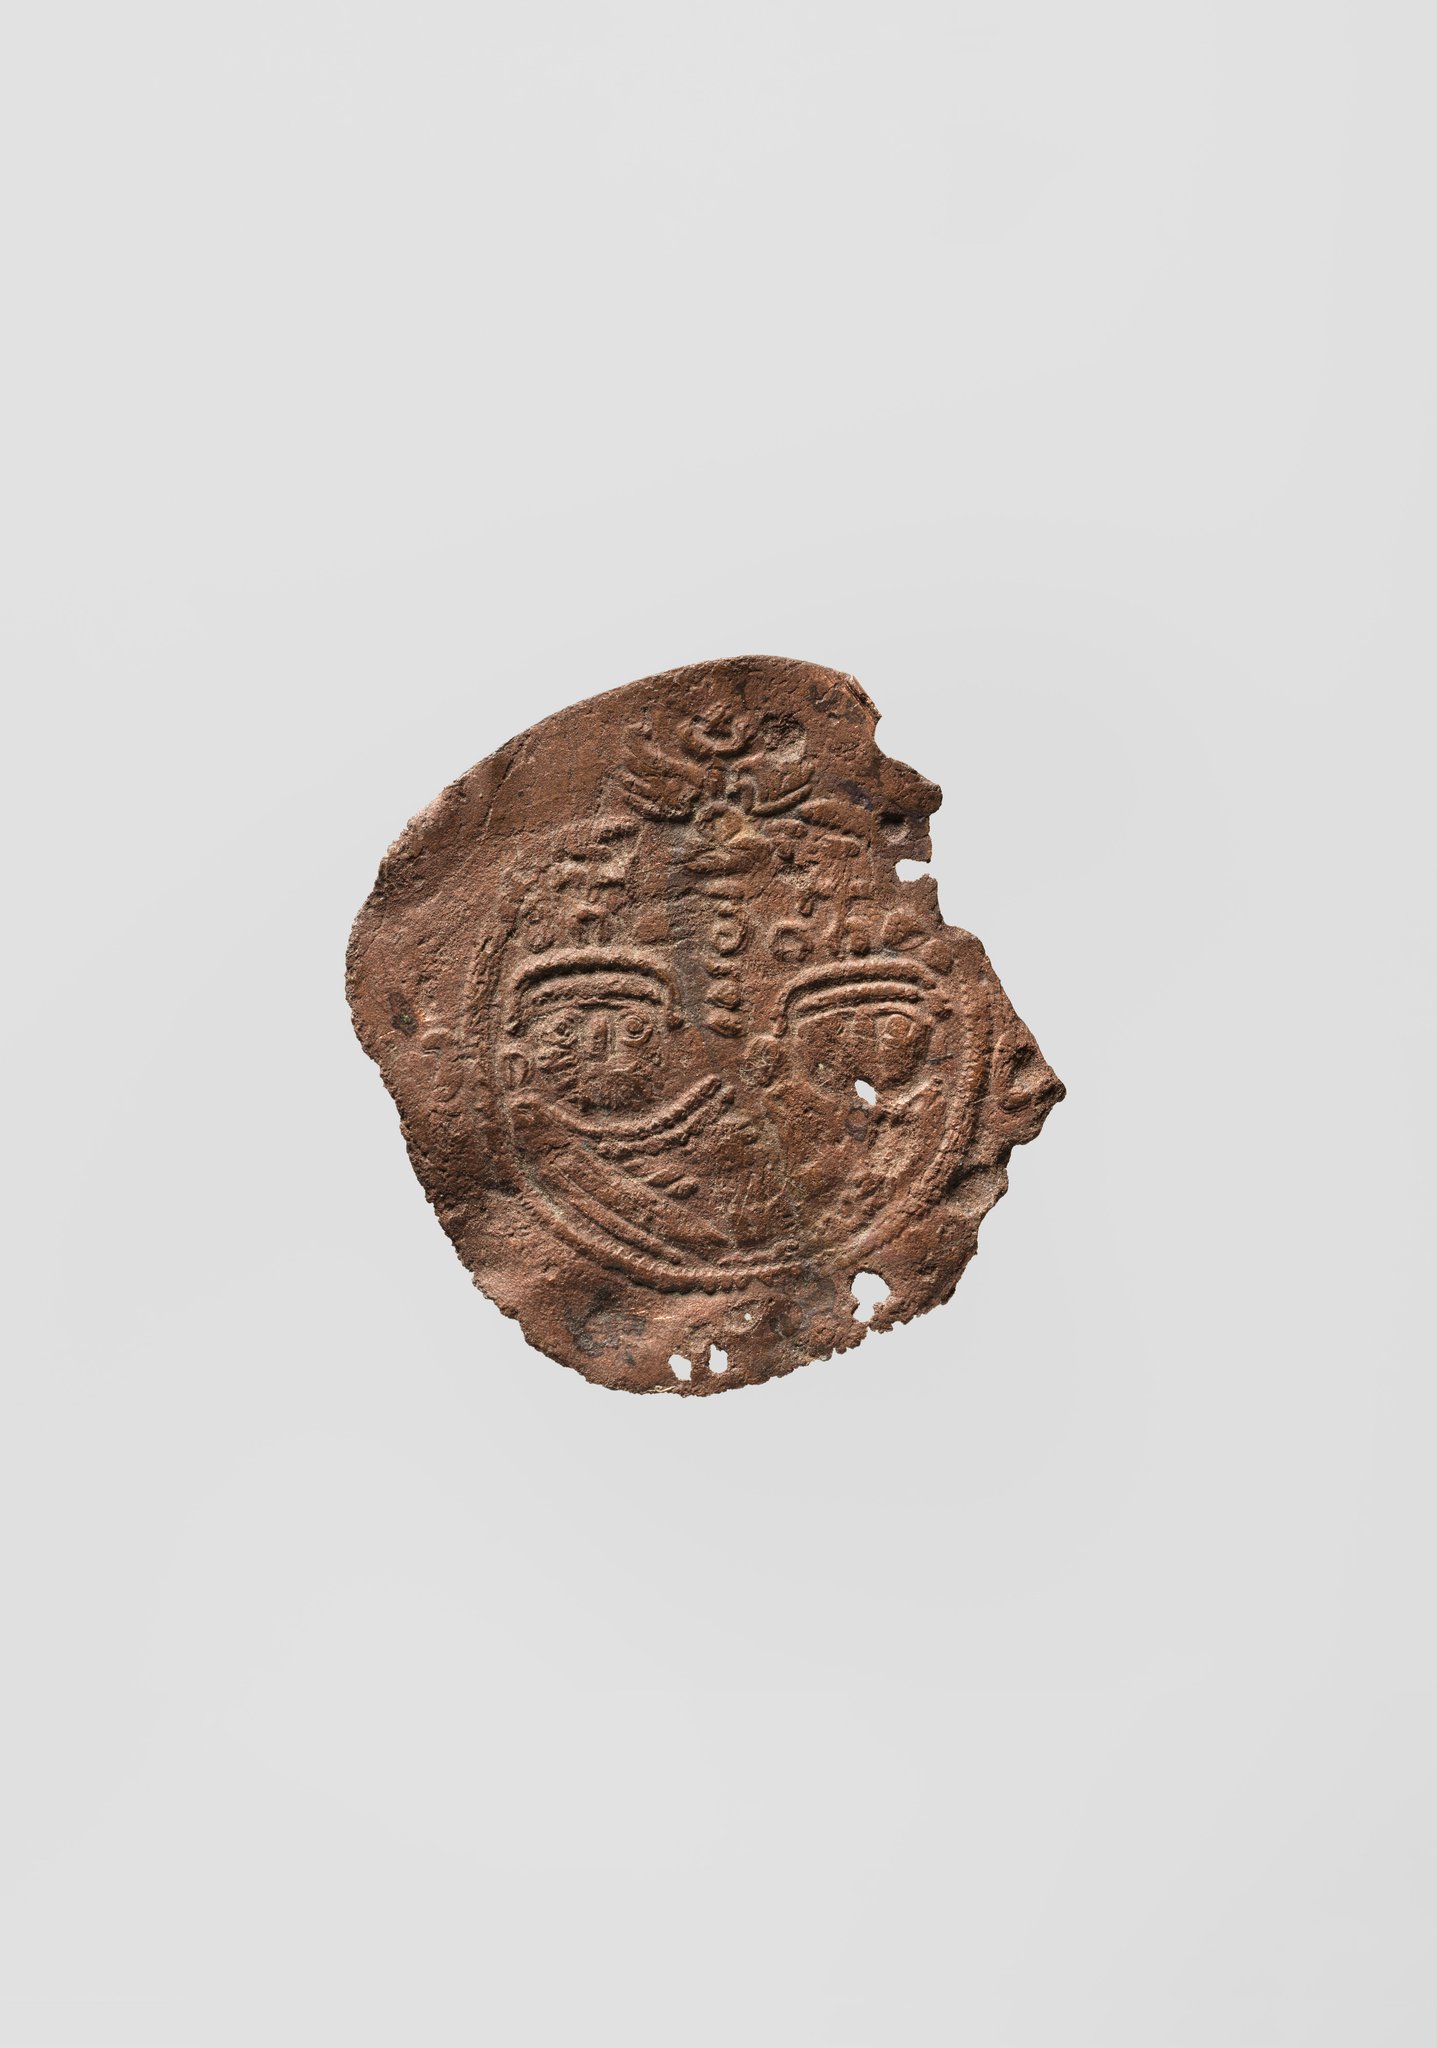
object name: coin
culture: islamic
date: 601-800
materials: copper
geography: iran